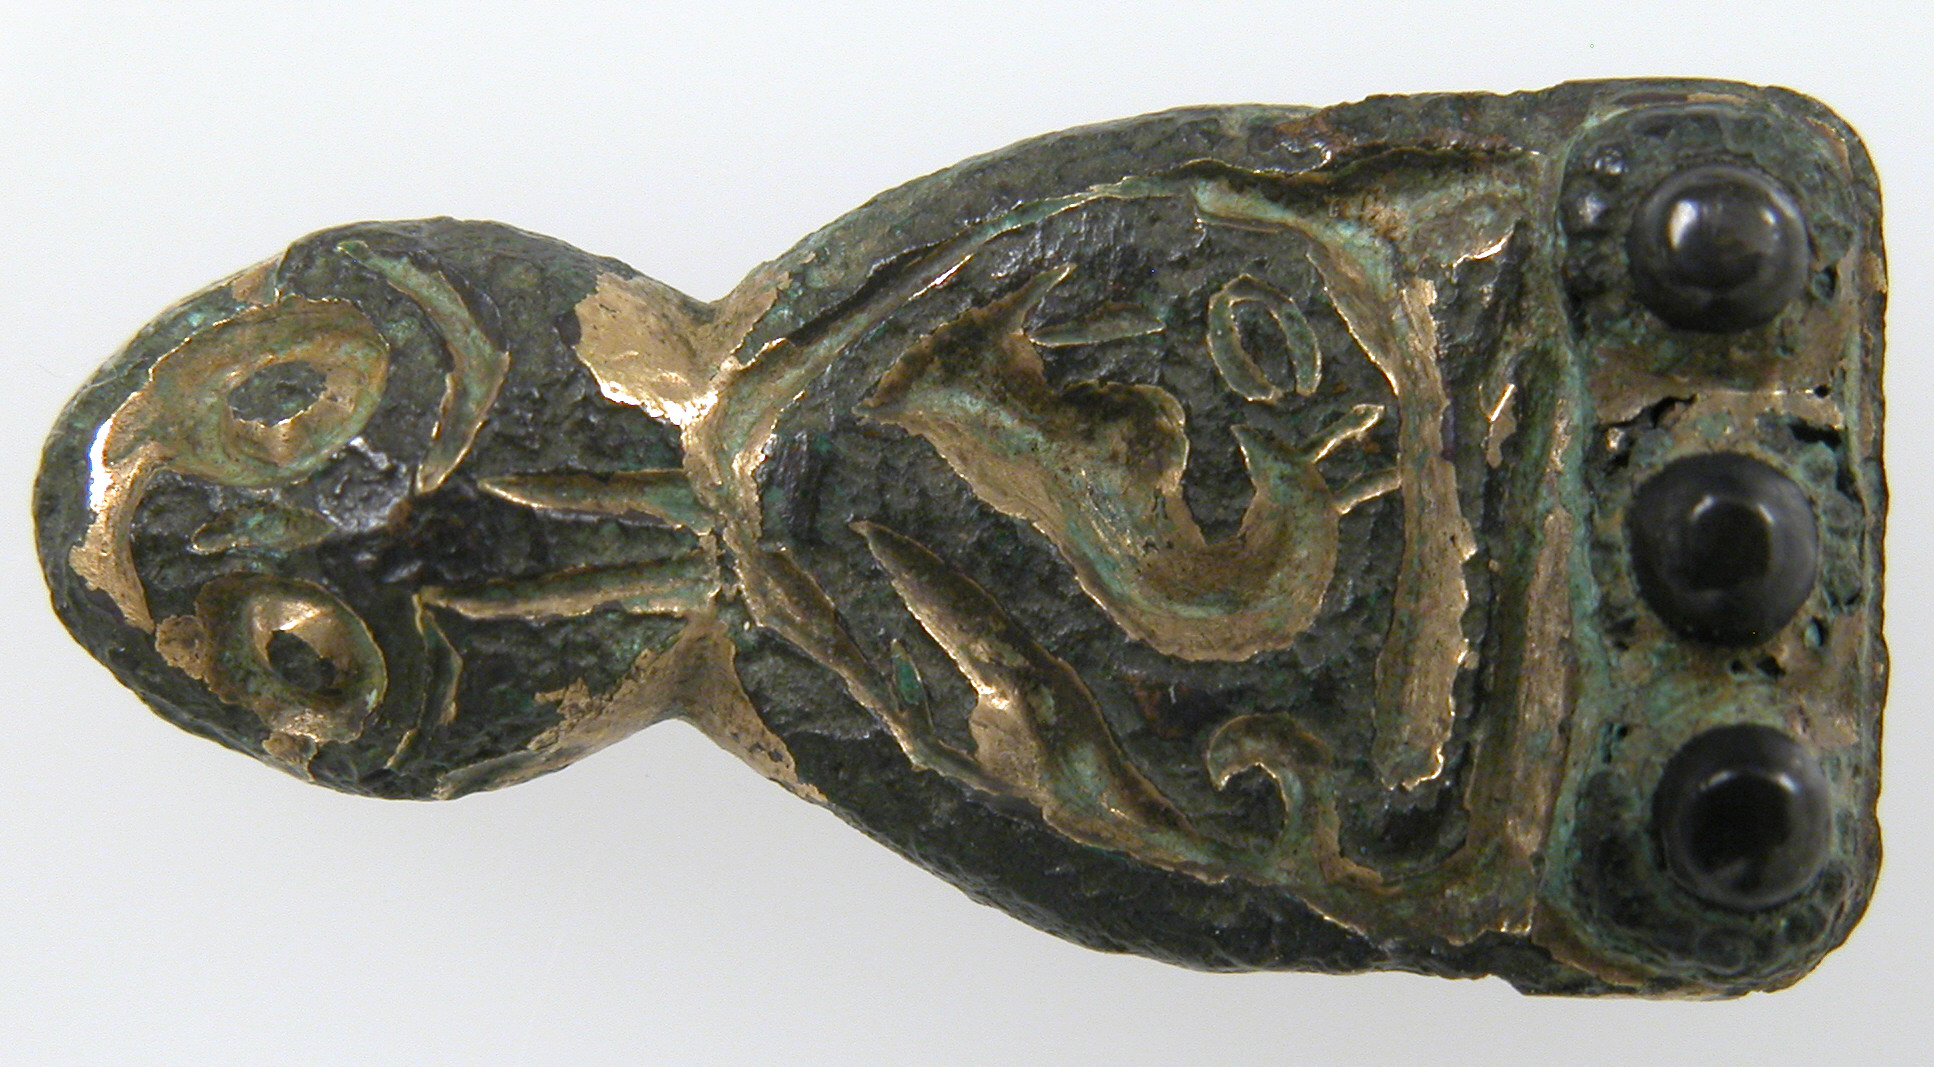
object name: clasp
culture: british or european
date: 501-800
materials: copper alloy, gilt